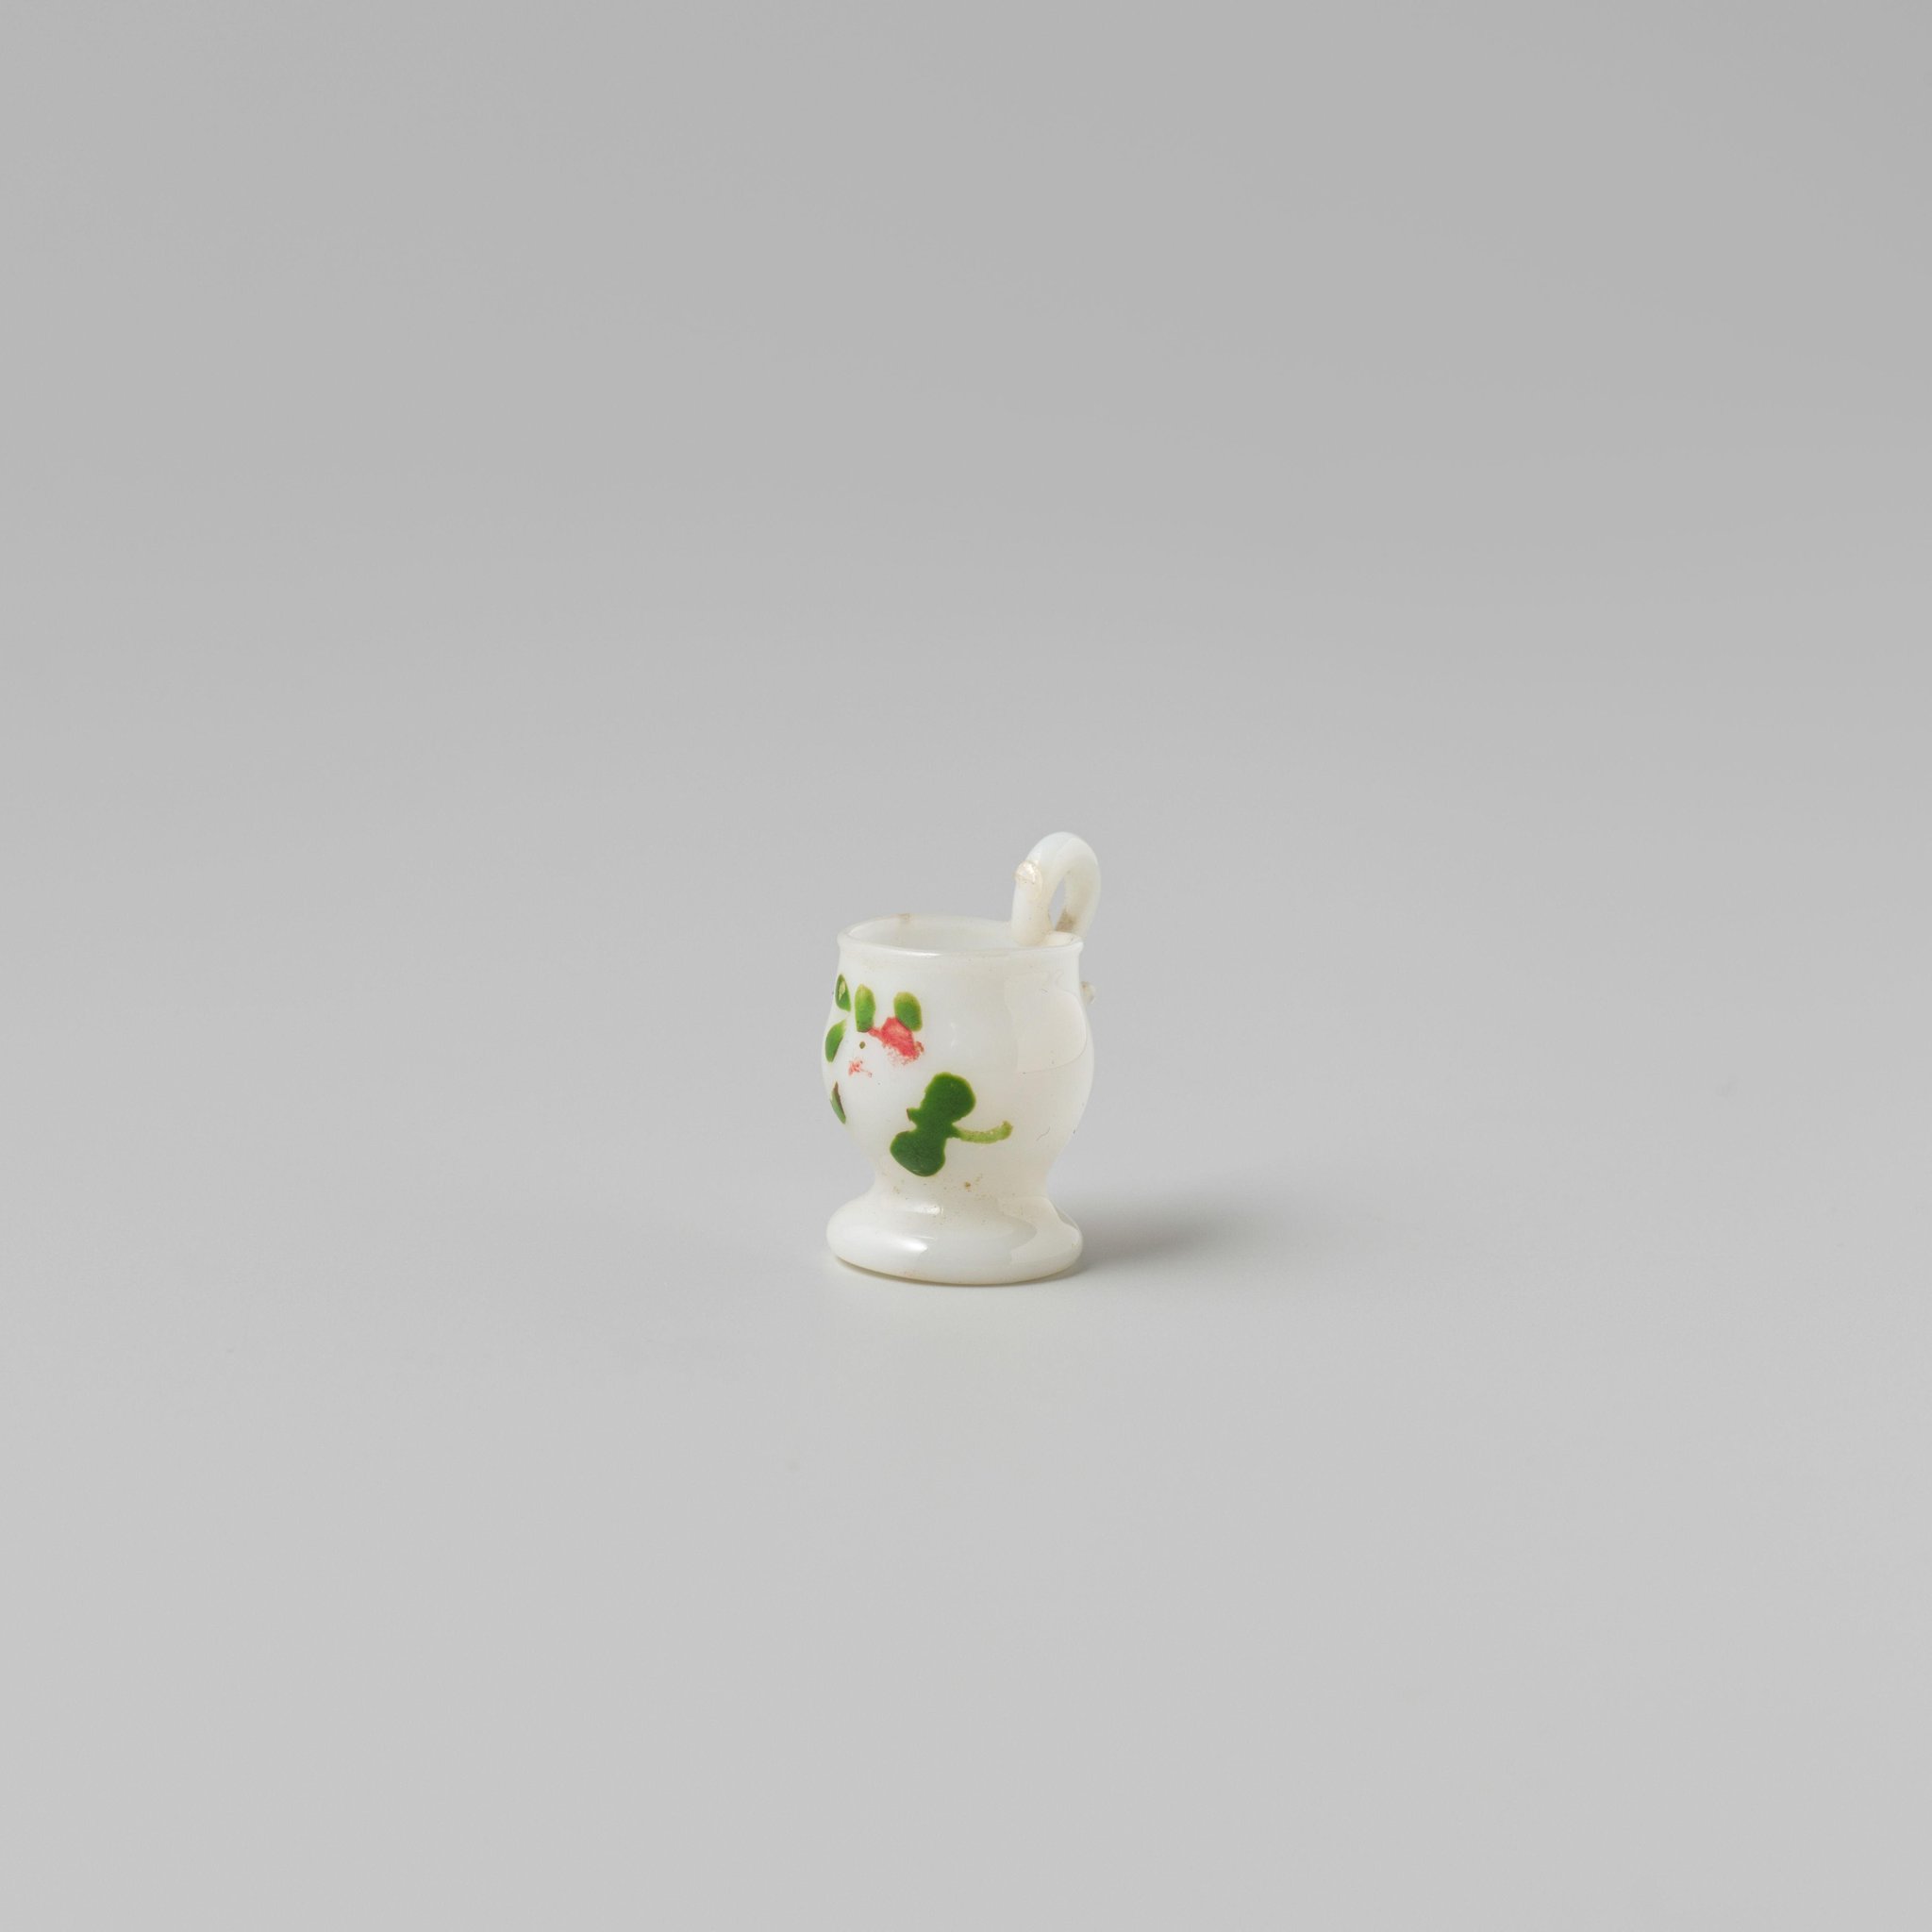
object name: miniature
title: Kop met oor, beschilderd met bloem in wit, rood en groen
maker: Anonymous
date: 1800-1849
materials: glass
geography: bristol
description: Kop van opaak wit glas, bol model op voet, met s-vormig oor. De kop is beschilderd met een bloem in wit, rood en groen.